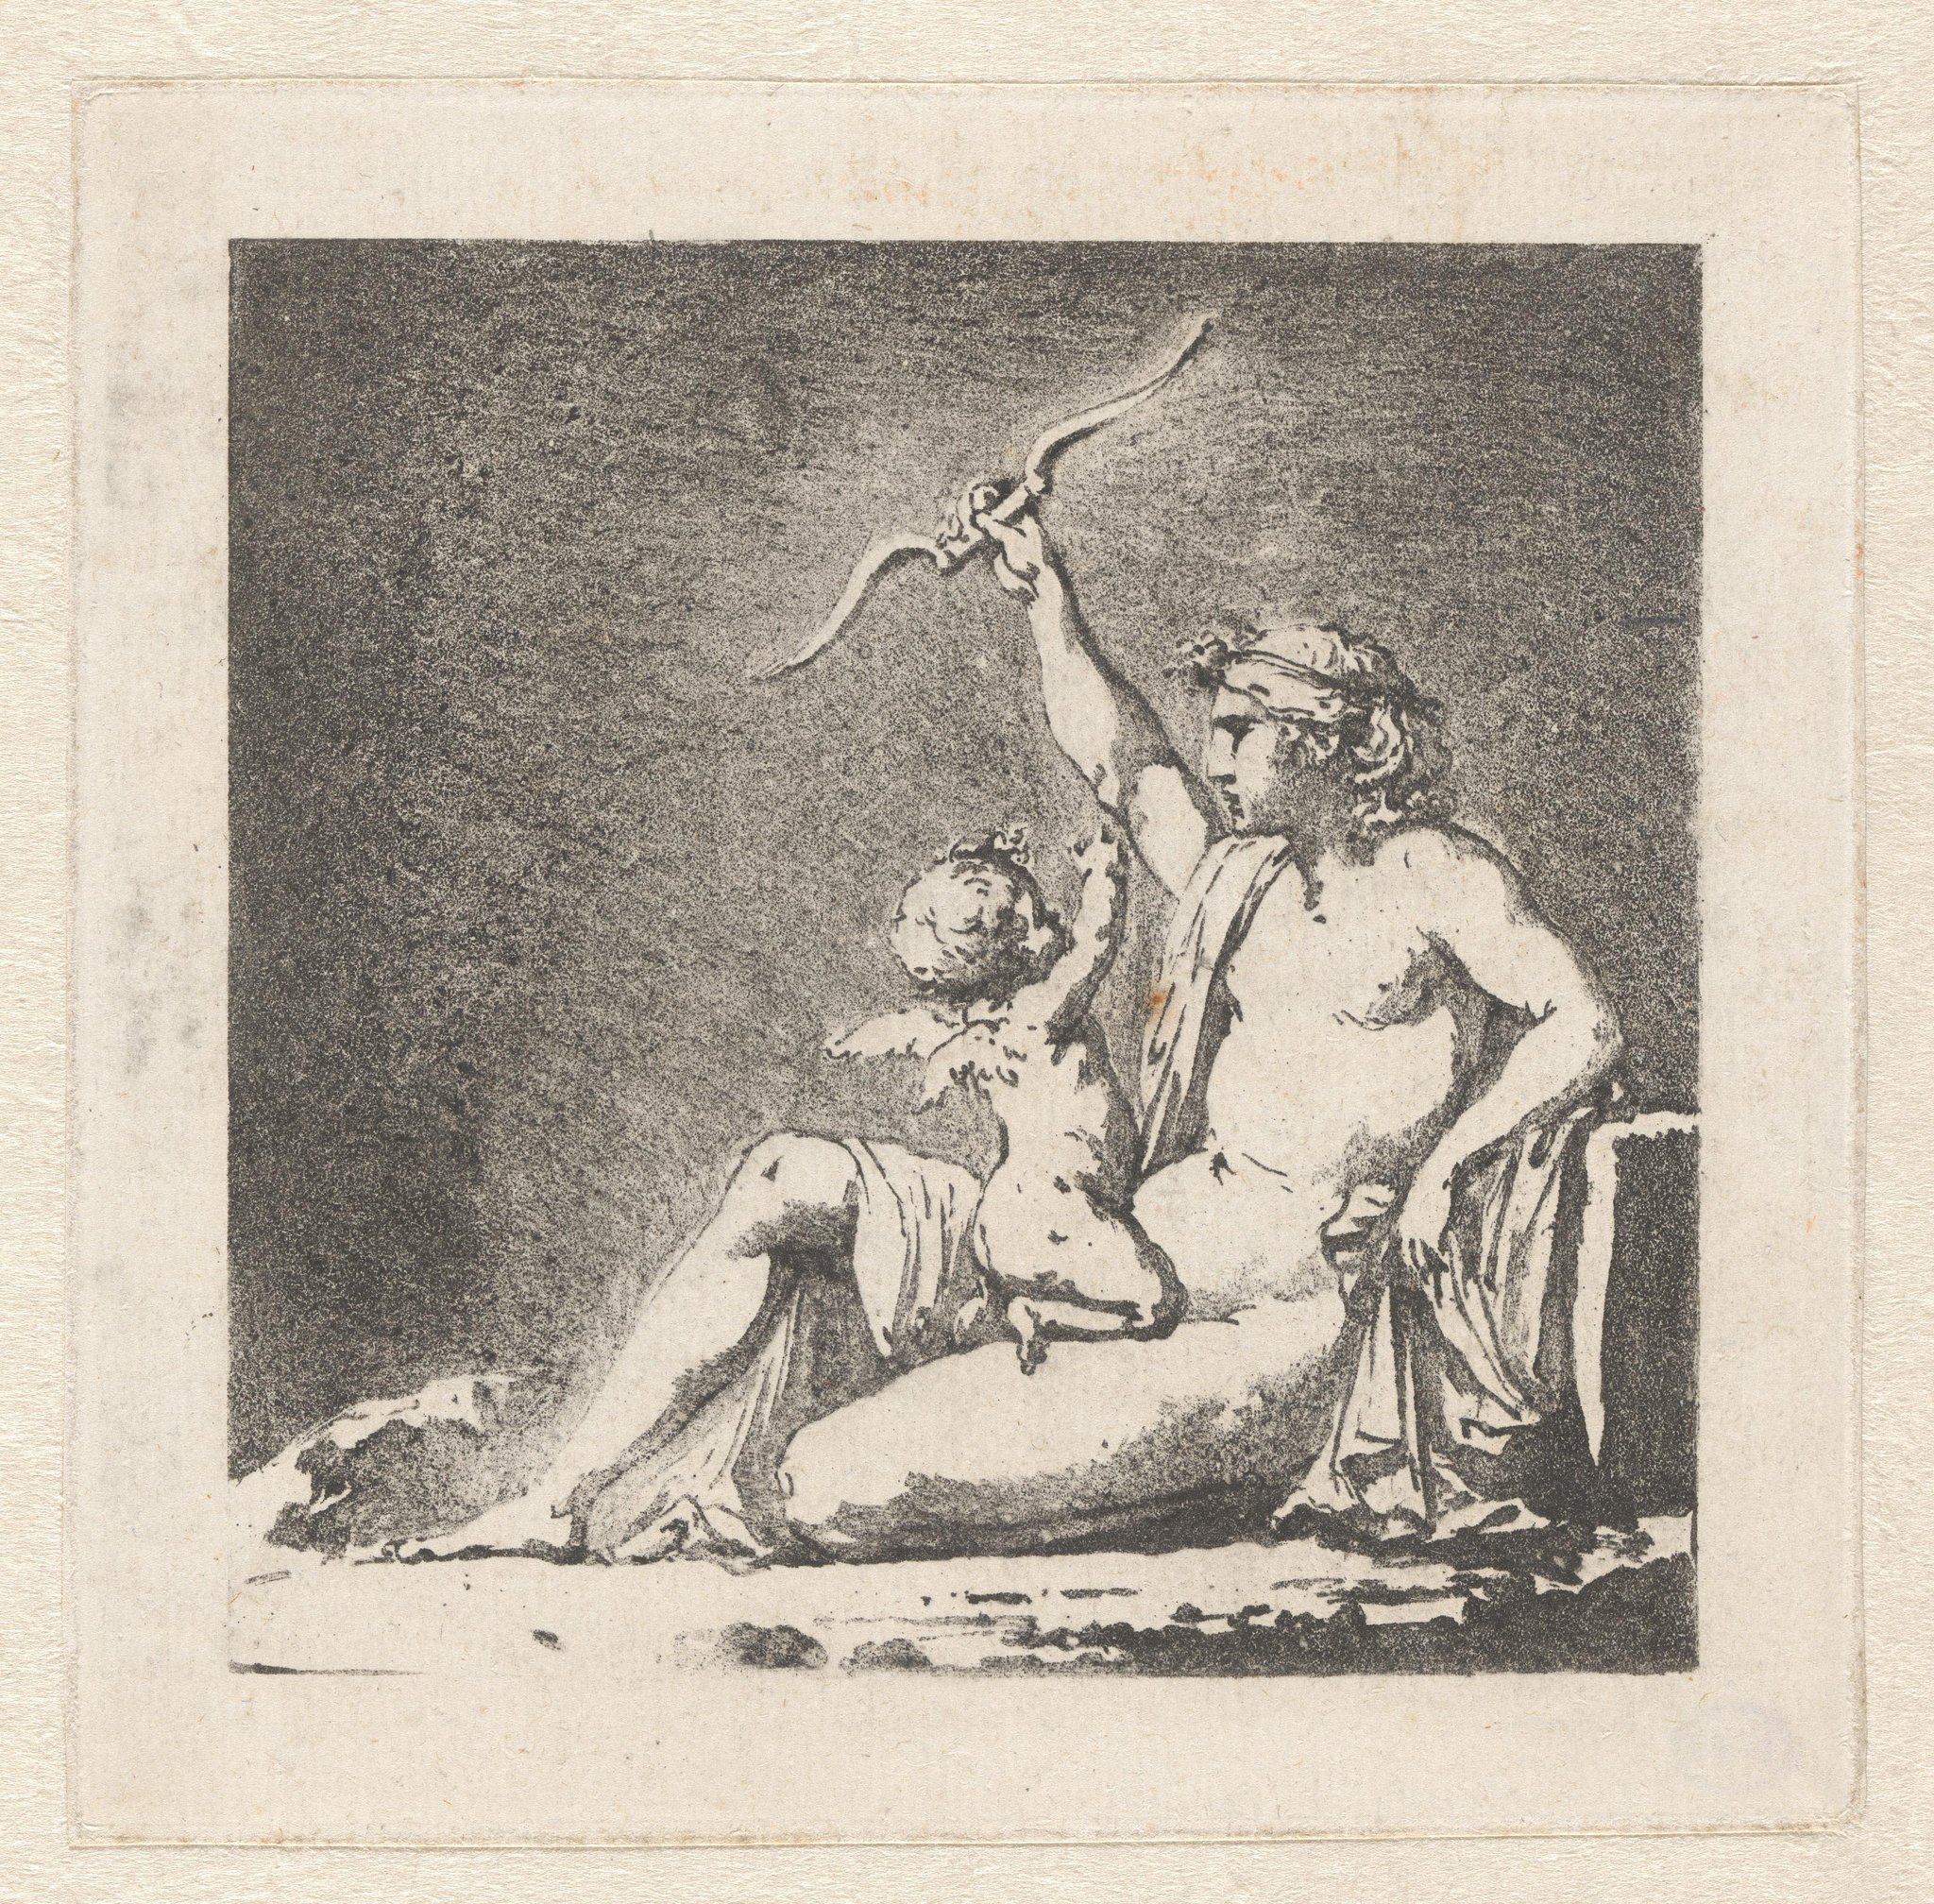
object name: print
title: Venus ontwapent Amor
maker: jean jacques ii lagrenée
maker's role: print maker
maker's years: 1739-1821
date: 1780-1790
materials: ink, paper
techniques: aquatint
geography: paris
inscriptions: collector's mark: Lugt 3373